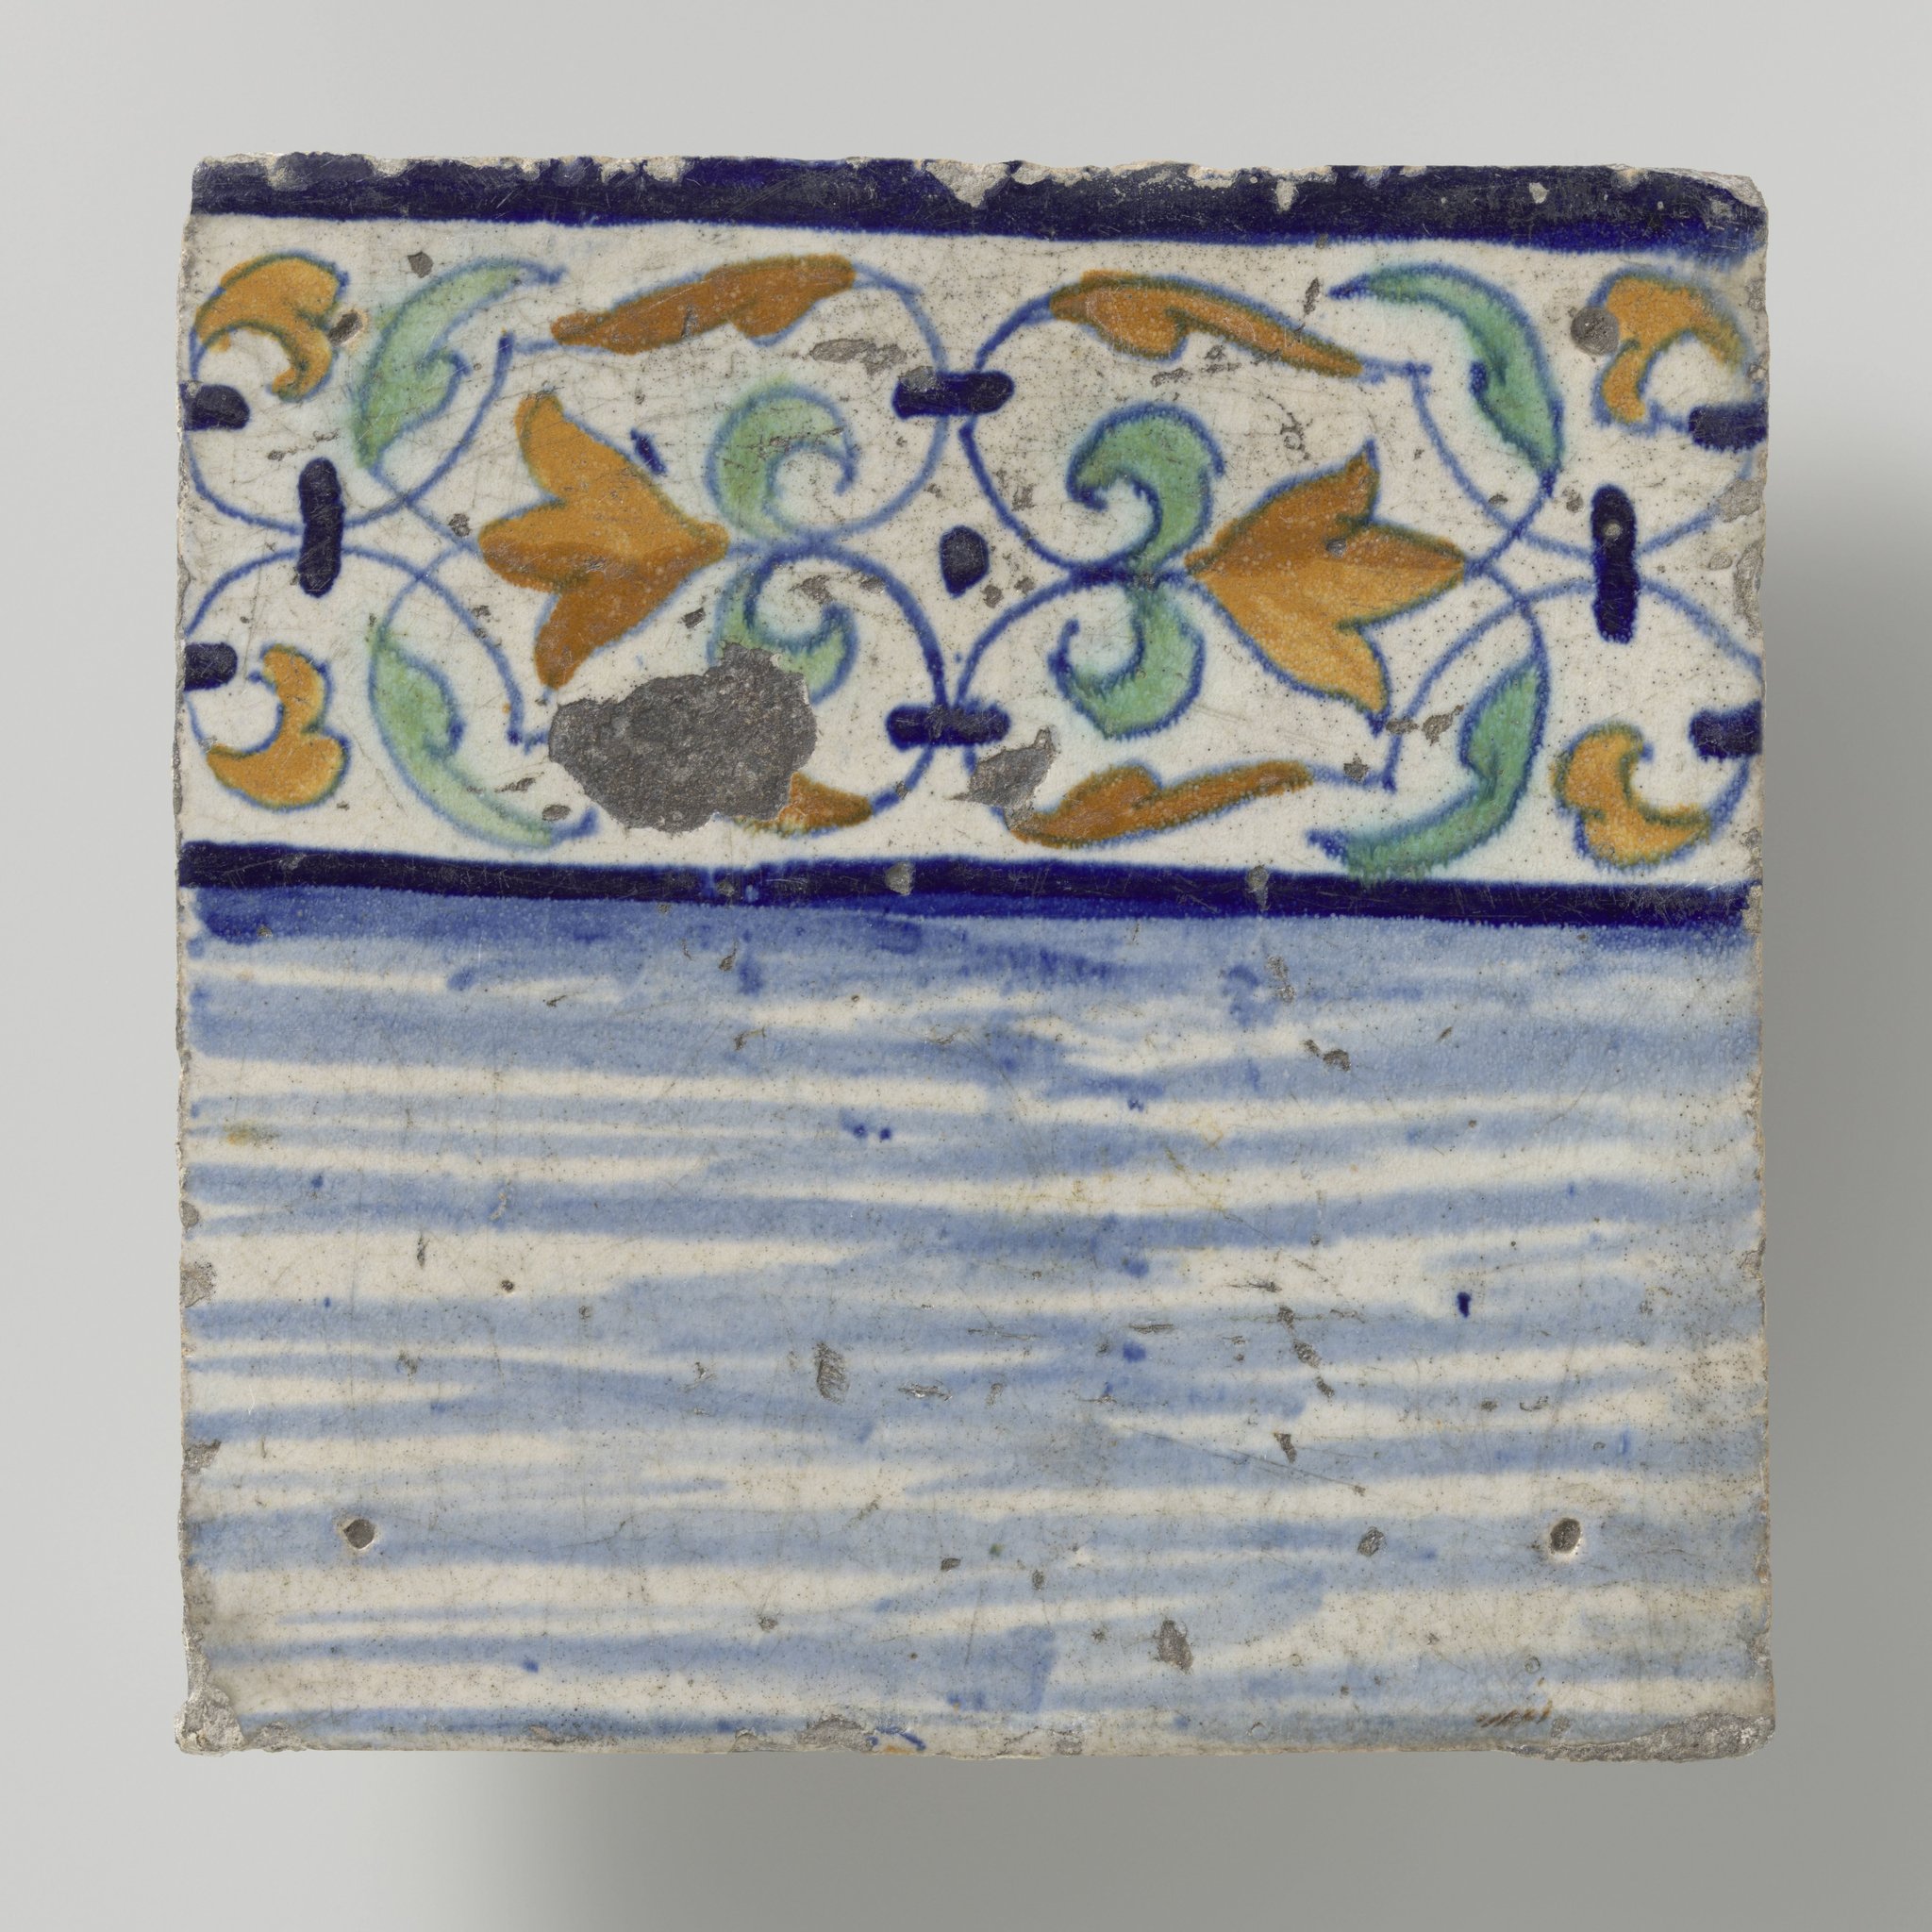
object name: tile tableau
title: Tegeltableau met ruiter in harnas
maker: Anonymous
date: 1600-1620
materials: earthenware, glaze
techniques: maiolica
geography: netherlands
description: Een losse tegel behorende tot het tegeltableau ruiter in harnas.